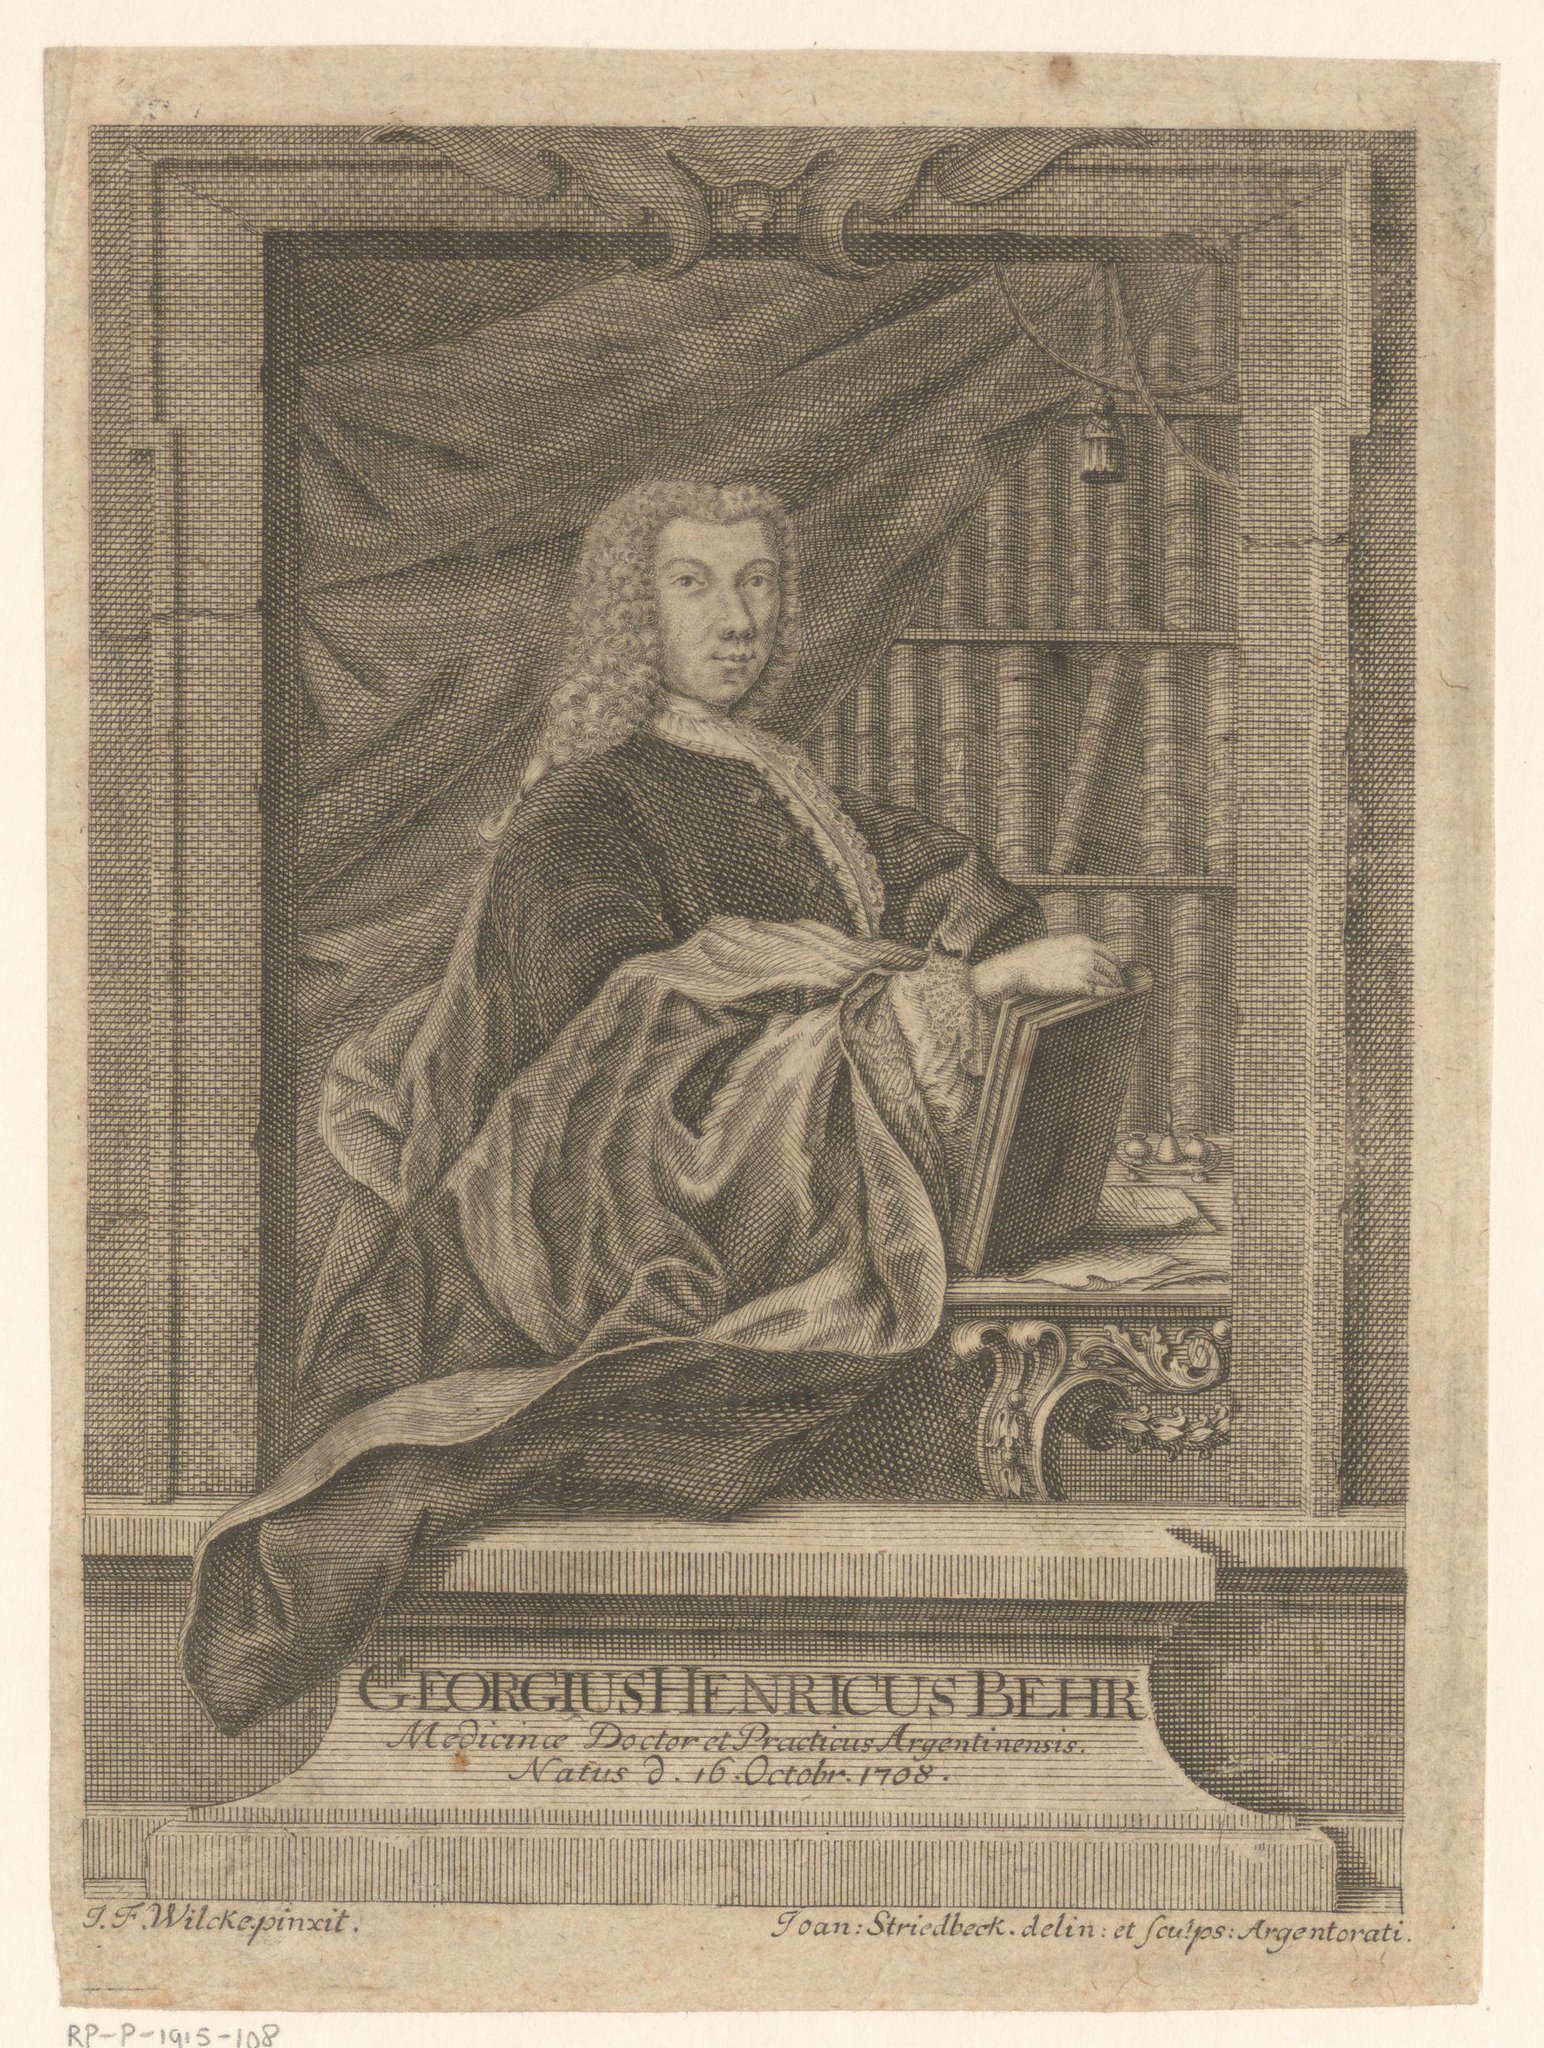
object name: print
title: Portret van Georg Heinrich Behr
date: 1731-1772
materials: paper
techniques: engraving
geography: straatsburg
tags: bookshelves, historical persons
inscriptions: collector's mark: Lugt 2228